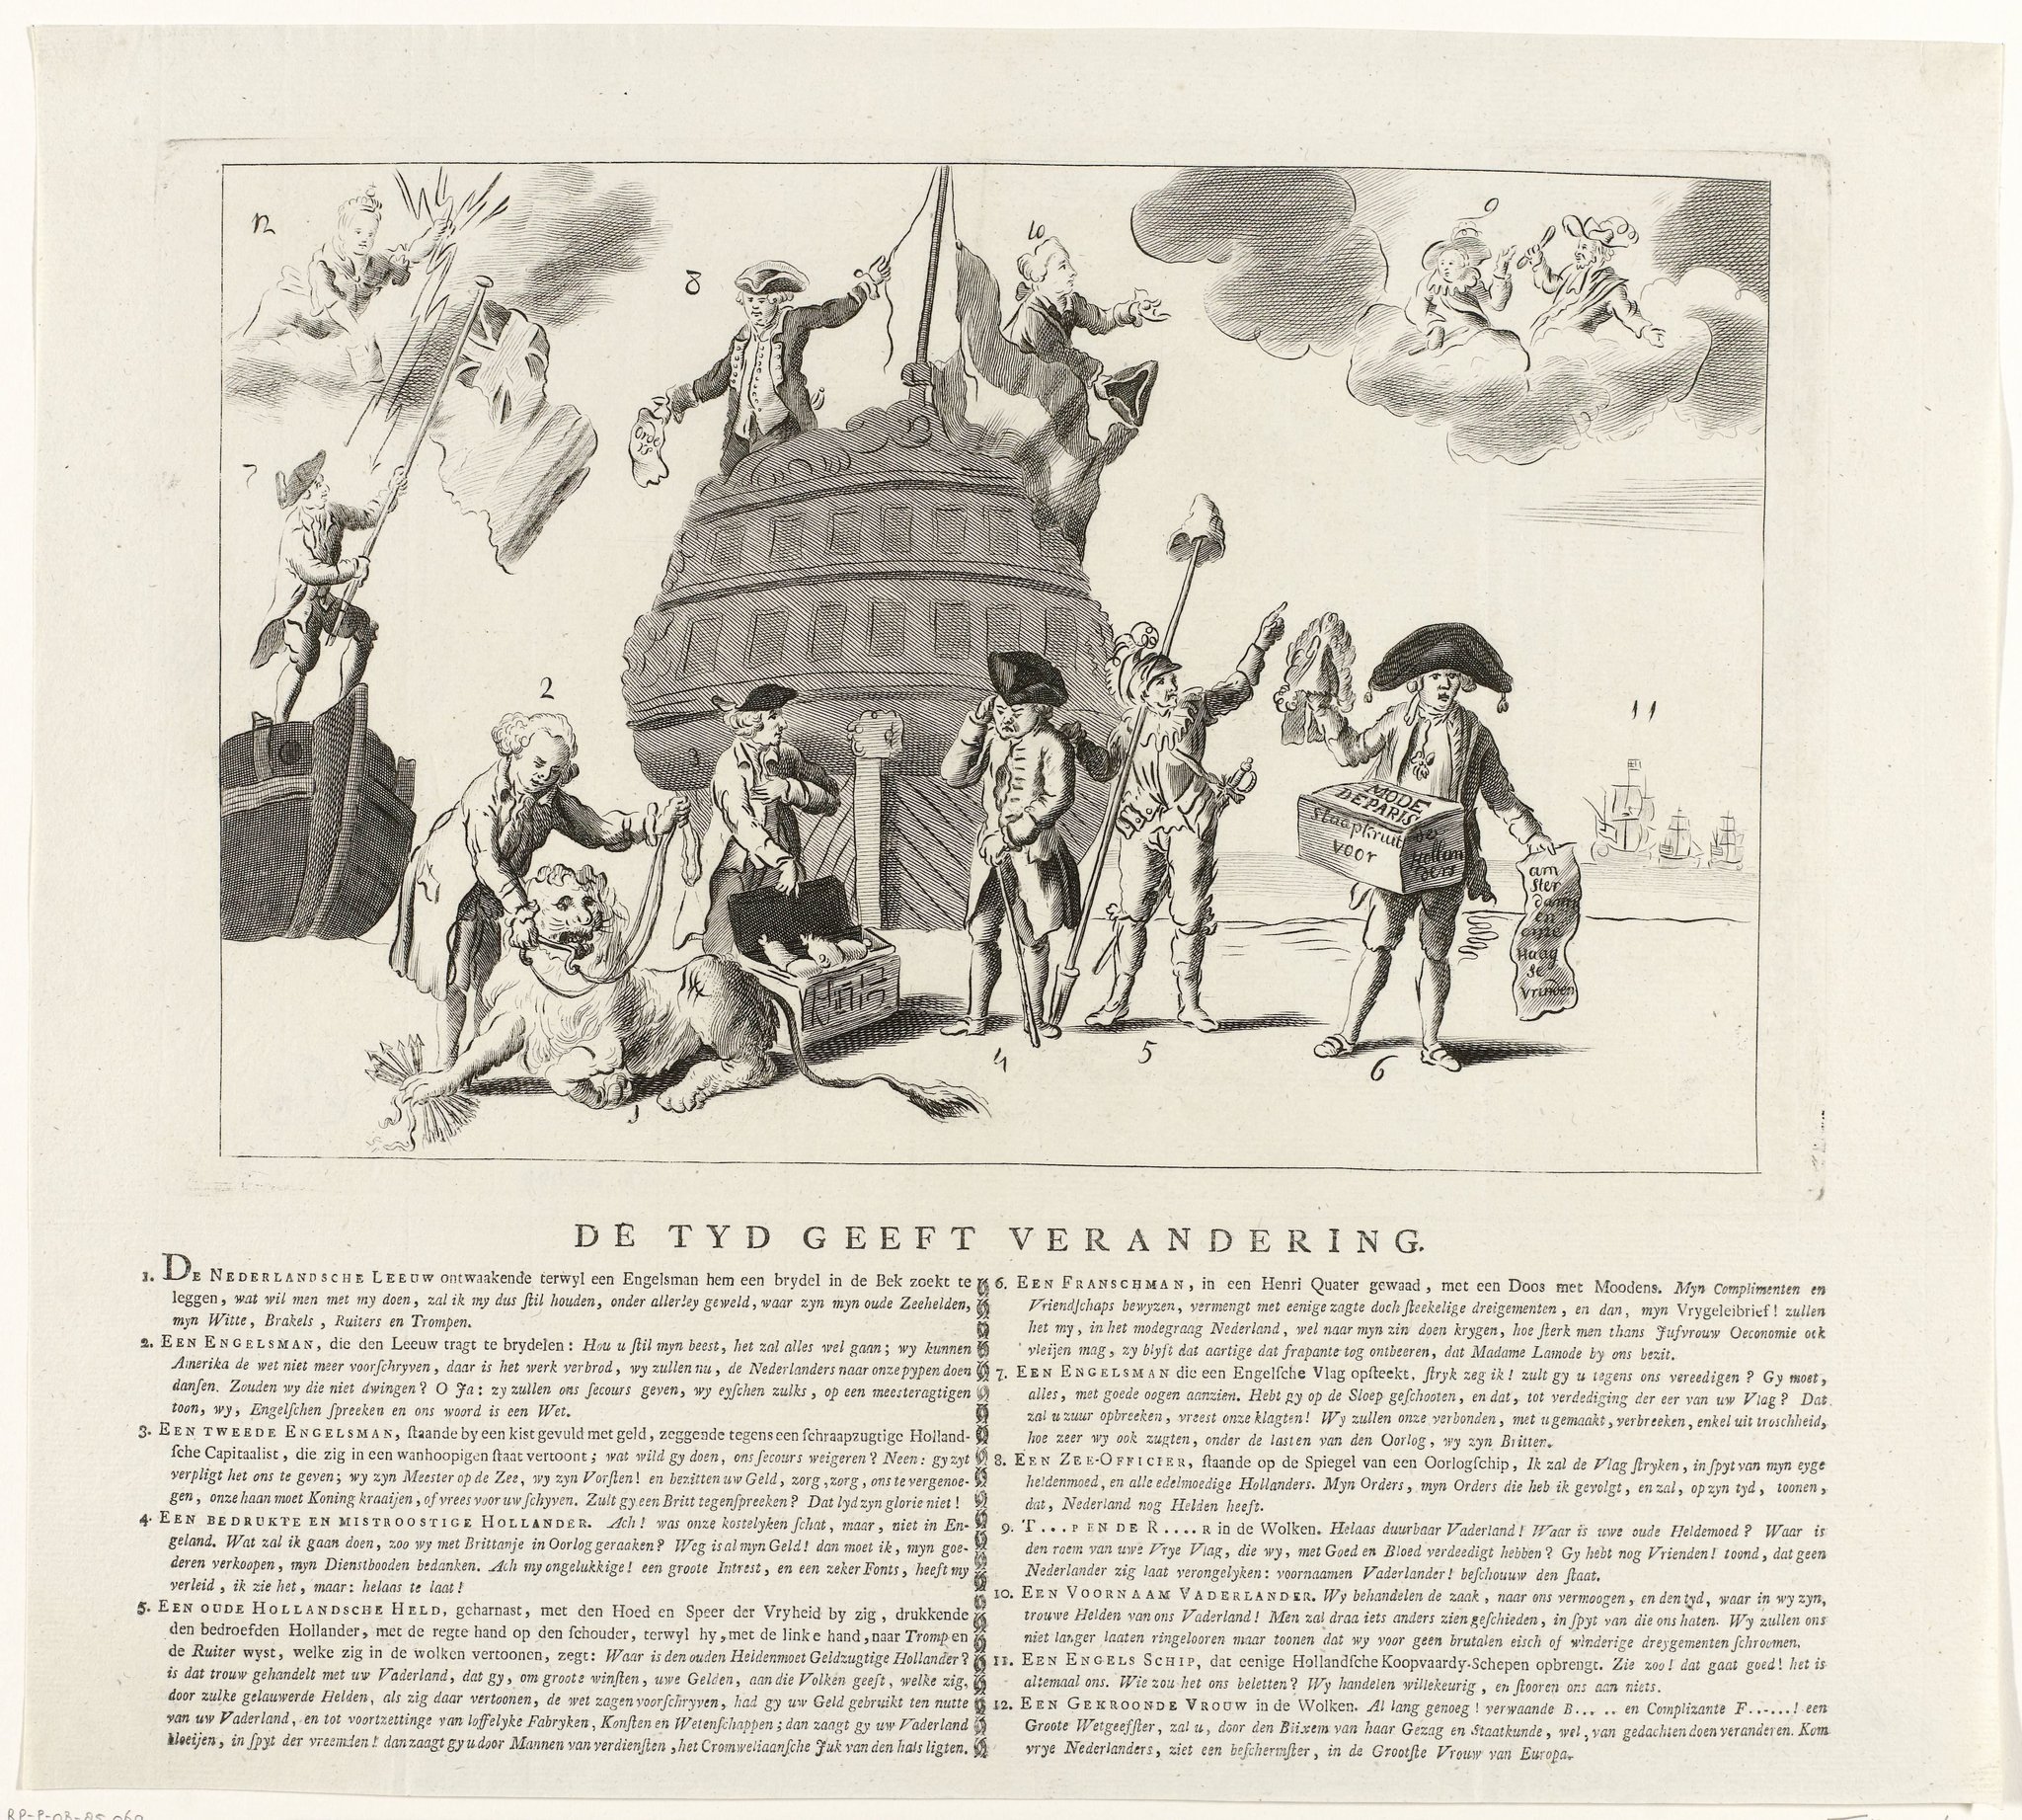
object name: print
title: De tyd geeft verandering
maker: Anonymous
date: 1780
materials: paper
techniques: engraving, etching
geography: northern netherlands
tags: flushing, michiel adriaenszoon de ruyter, brielle, maarten harpertszoon tromp, catharina de grote, political caricatures and satires, fourth anglo-dutch war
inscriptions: collector's mark: Lugt 2228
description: Spotprent op de oorlog tussen de Republiek en Engeland en het roemruchte verleden van Holland, ca. 1780. De Nederlandse Leeuw ontwaakt als een Engelsman hem wil breidelen. Centraal een Hollander treurend om het verlies van zijn kapitaal. Daarnaast wijst een Batavier in harnas naar Tromp en De Ruyter in de wolken. Op het blad onder de plaat de verklaring van de cijfers 1-12.